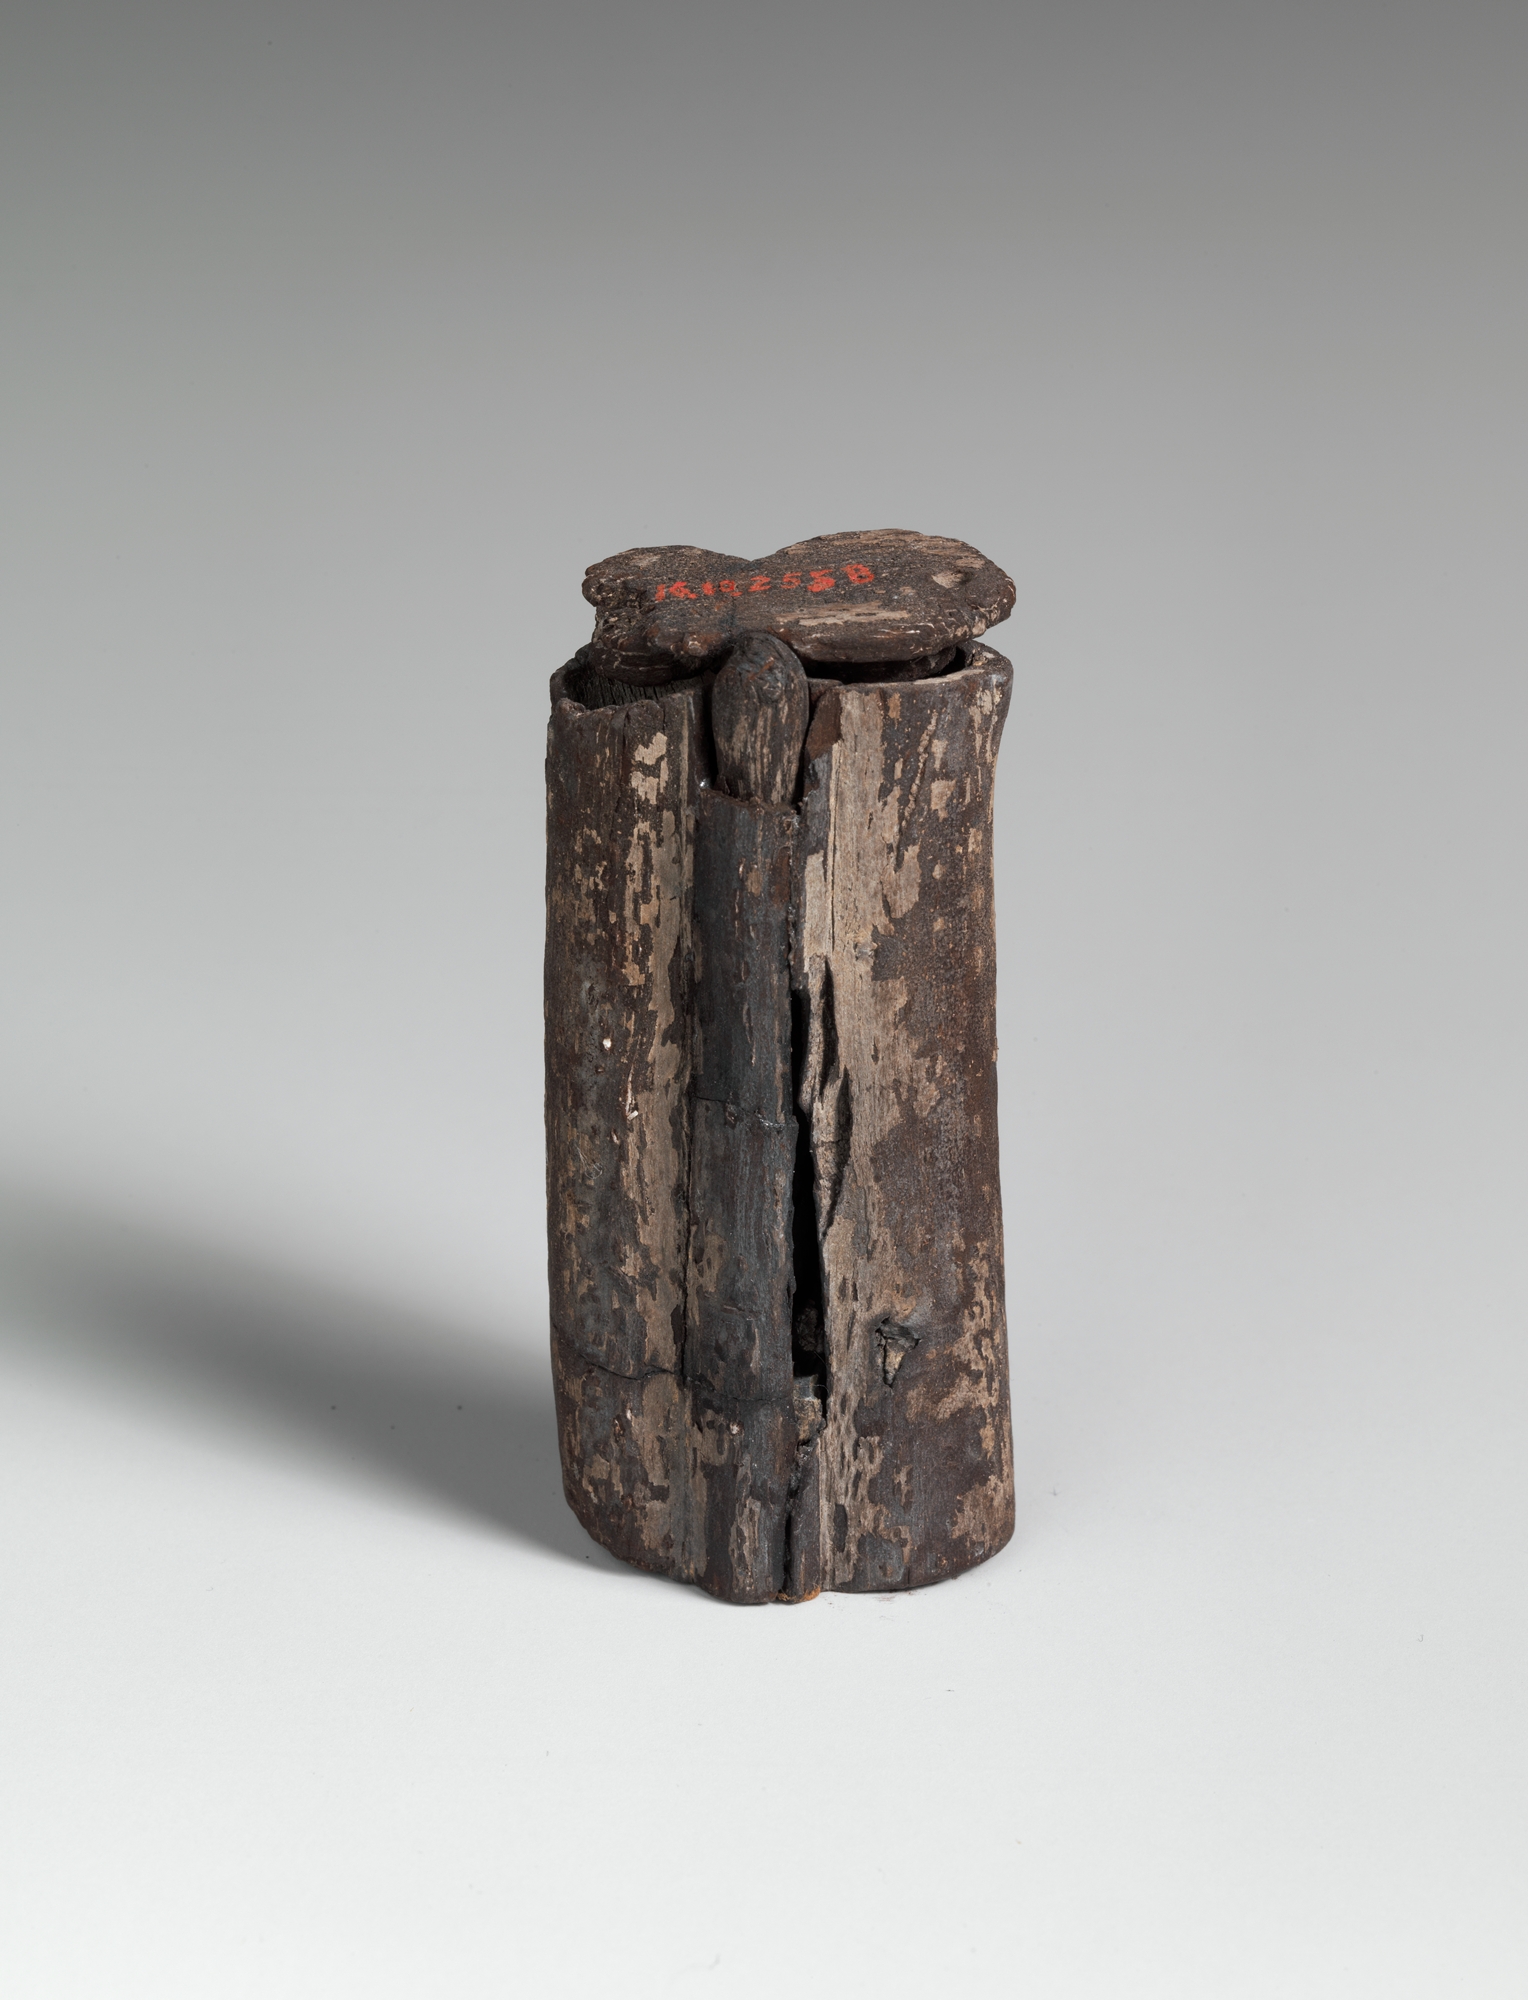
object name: kohl tube, stick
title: Kohl Tube and Stick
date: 1635-1458 BCE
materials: wood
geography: egypt